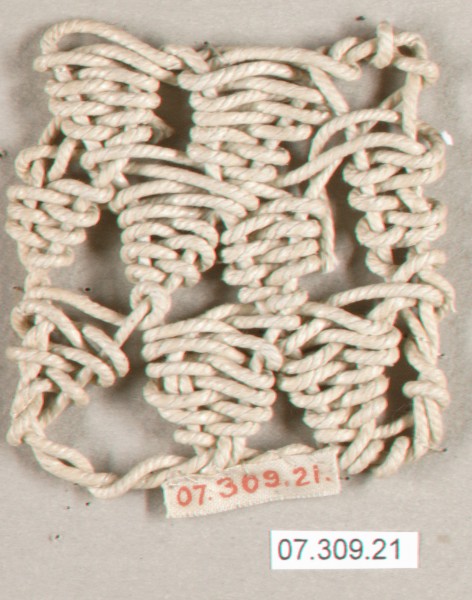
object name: stitch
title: Example of lace stitch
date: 1801-2000